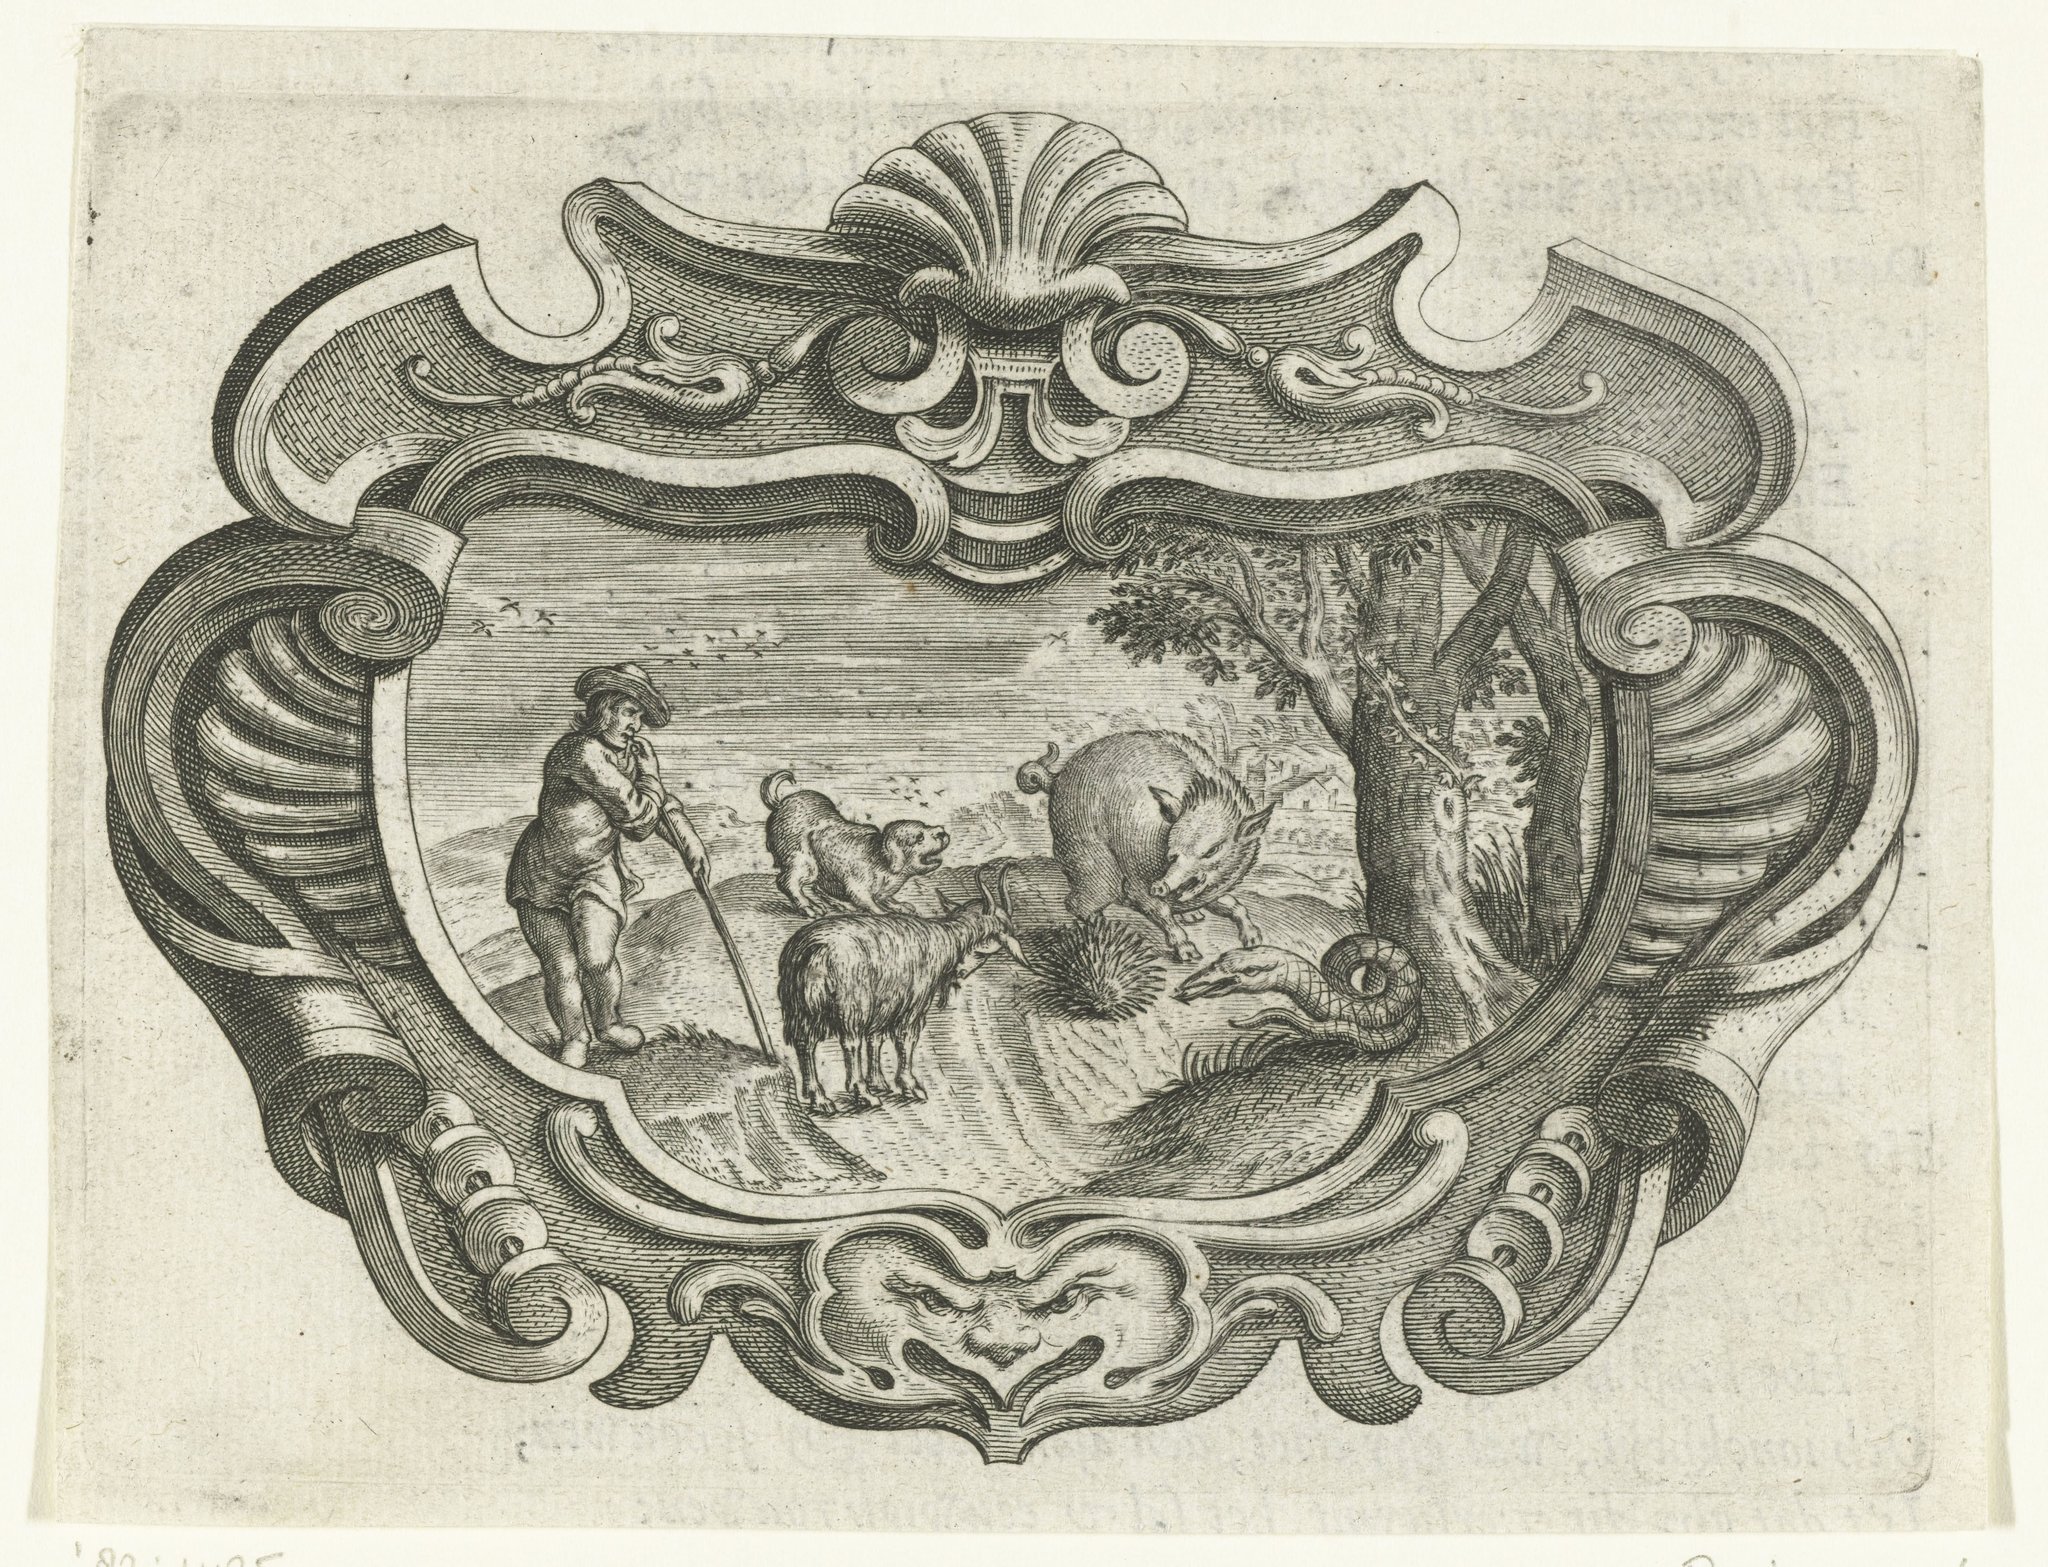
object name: print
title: Rolwerkcartouche met dieren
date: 1640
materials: paper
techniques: engraving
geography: antwerp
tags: dog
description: Links staat een man met een stok in de hand, in het midden staan een hond, everzwijn, slang en geit naar een opgerolde egel gekeerd. Uit serie van 38 cartouches, gedecoreerd met maskers, guirlandes van fruit en bloemen, schelpen en dieren.